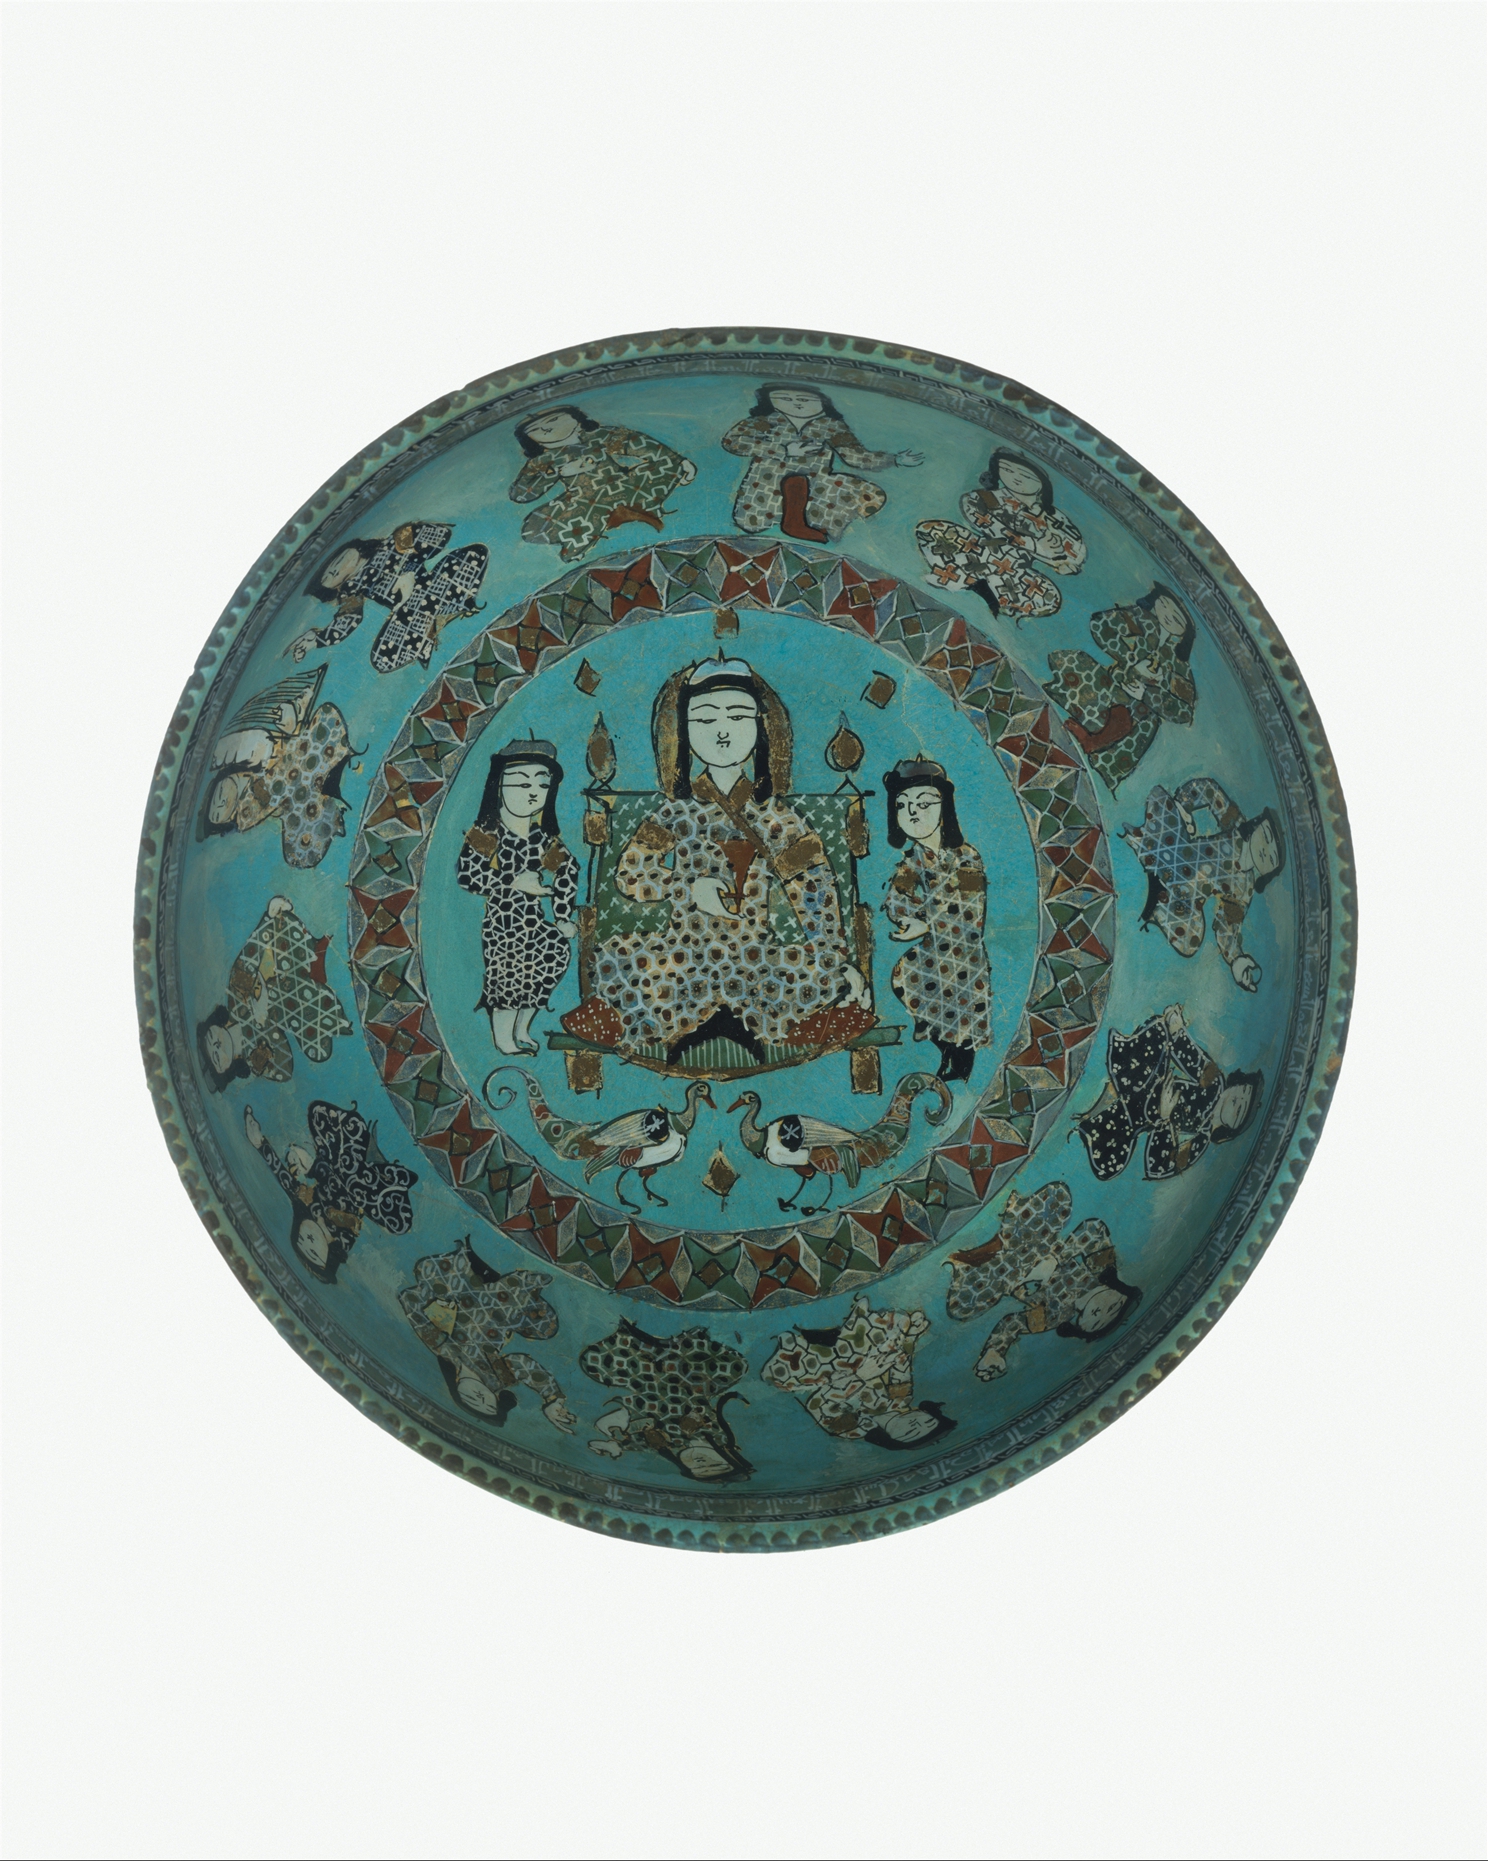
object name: bowl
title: Bowl with a Ruler and Attendants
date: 1101-1300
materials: glaze, stonepaste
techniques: gilding, overglaze, painting, polychrome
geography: iran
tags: human figures